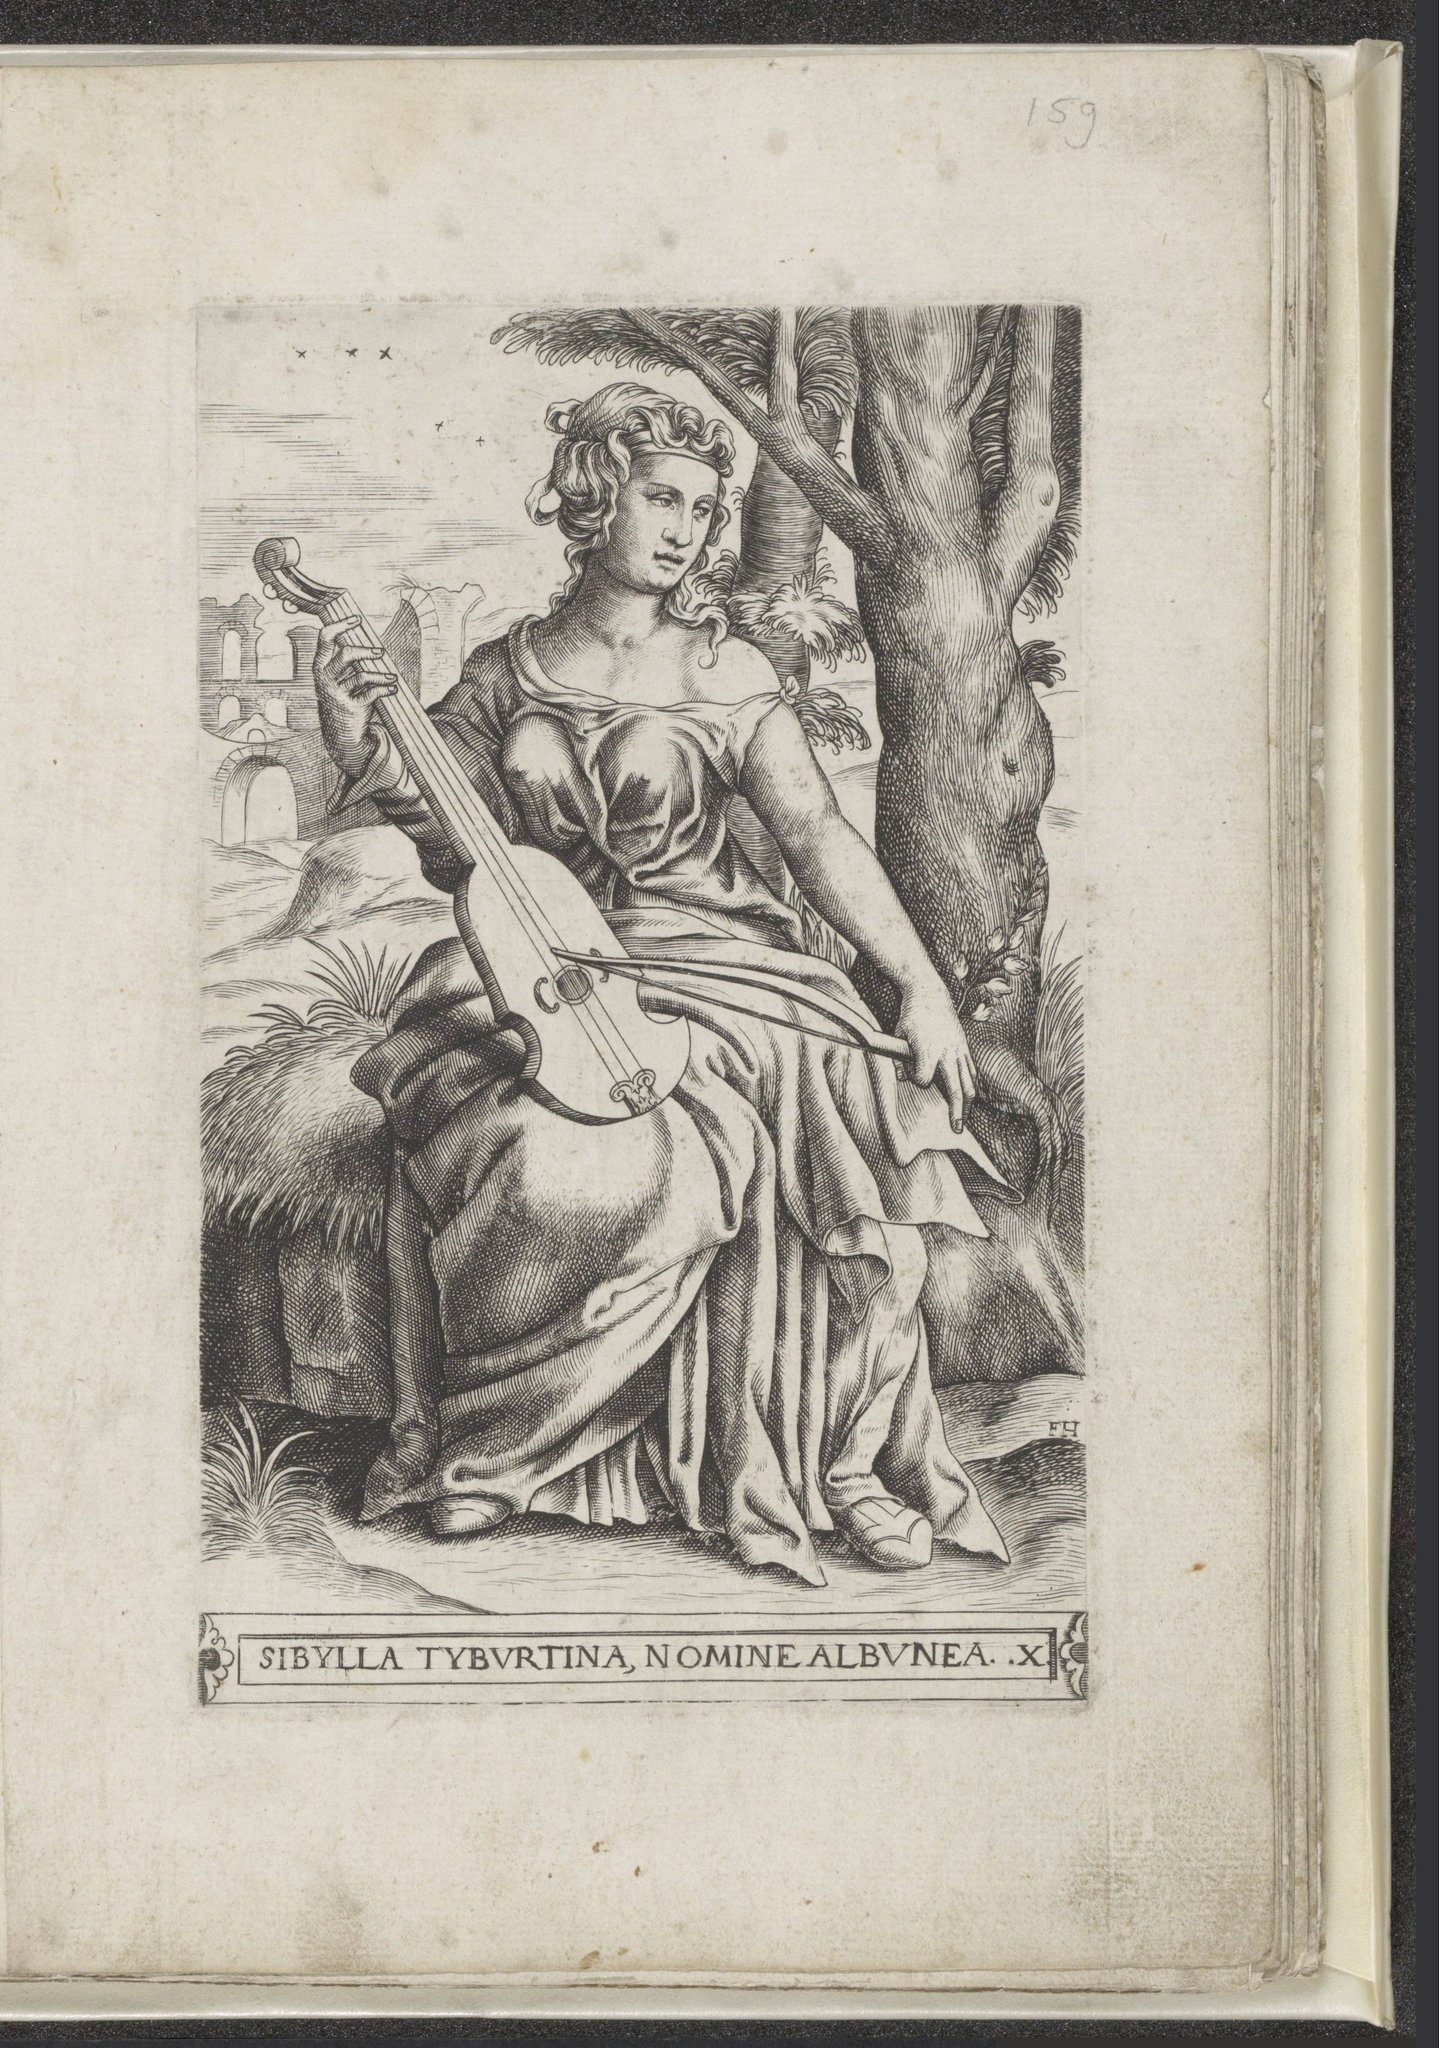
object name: print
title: Tiburtijnse Sibille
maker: frans huys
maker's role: print maker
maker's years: 1522-1562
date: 1546-1562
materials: paper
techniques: engraving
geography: antwerp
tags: sibyls (with name)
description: De Tiburtijnse Sibille zittend met een viool en strijkstok onder een boom. Op de achtergrond links een ruïne. Deze prent maakt deel uit van een album.